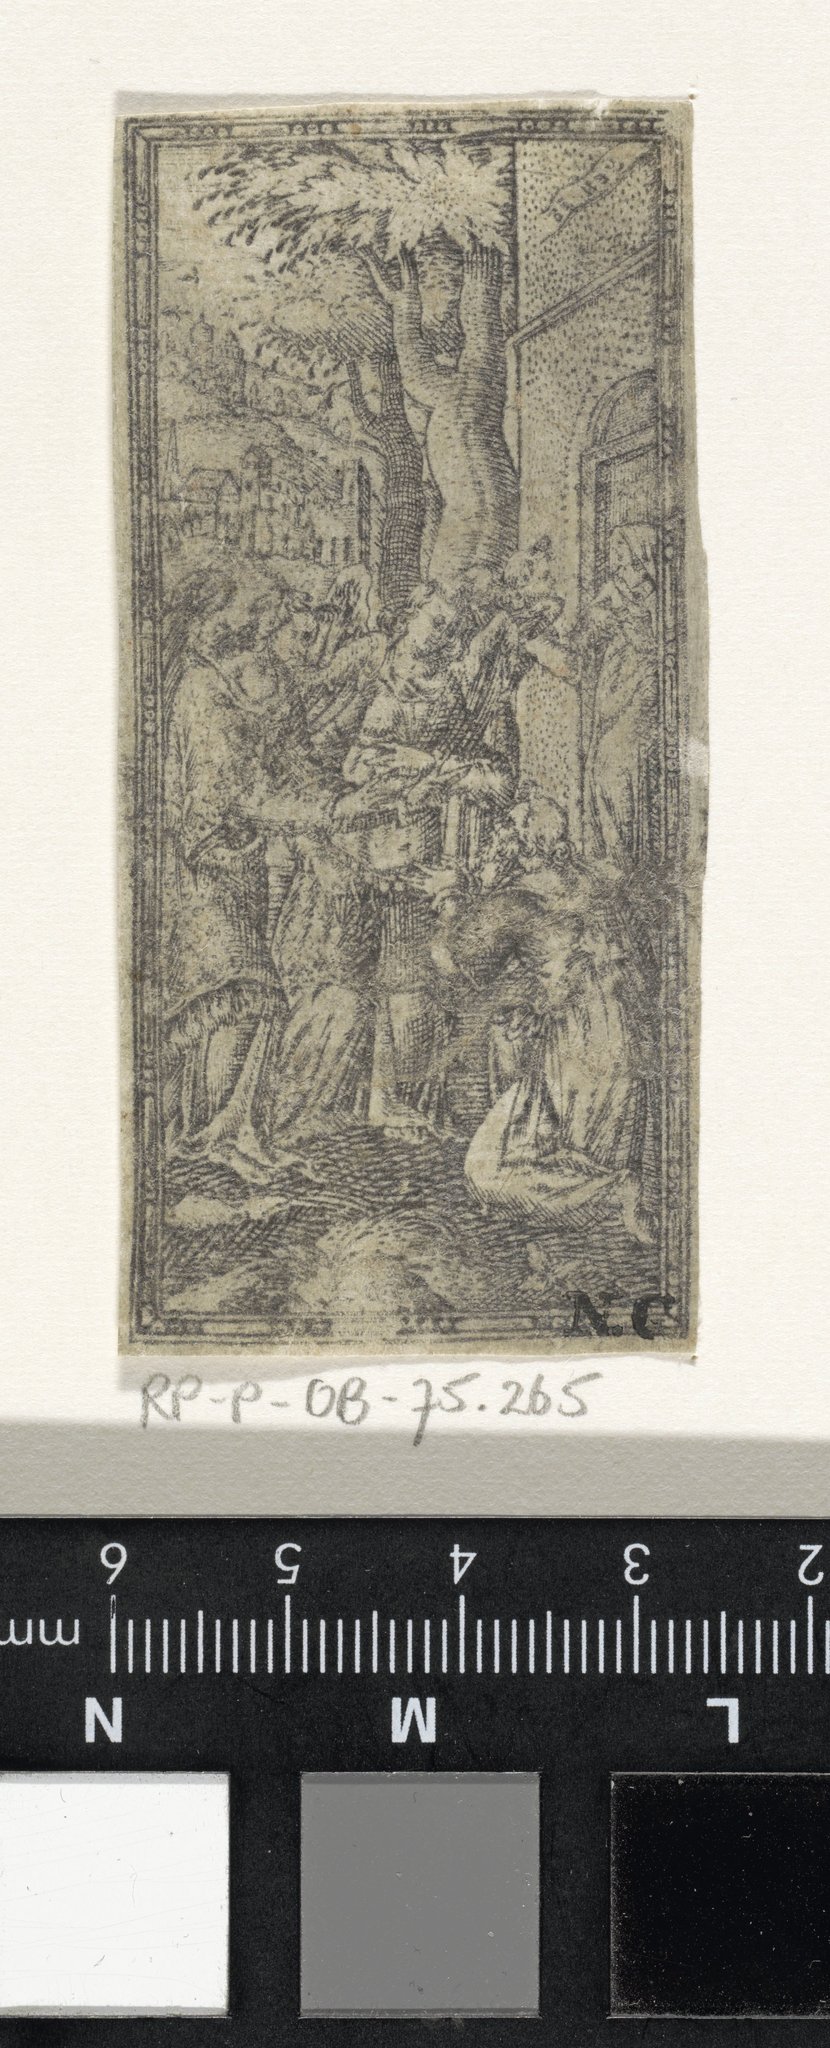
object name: print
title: Abraham en de drie engelen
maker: Anonymous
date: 1500-1600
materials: paper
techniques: engraving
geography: netherlands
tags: abraham kneels before the angels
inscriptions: collector's mark: Lugt 1967, collector's mark: Lugt 2228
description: Abraham ontvangt de drie engelen voor zijn huis en knielt voor hen. Zij beloven hem dat hij met Sara een zoon krijgt. Sara luistert rechts in de deuropening mee. In de rechterbovenhoek op de gevel een verwijzing naar Gen. 13 in spiegelbeeld.